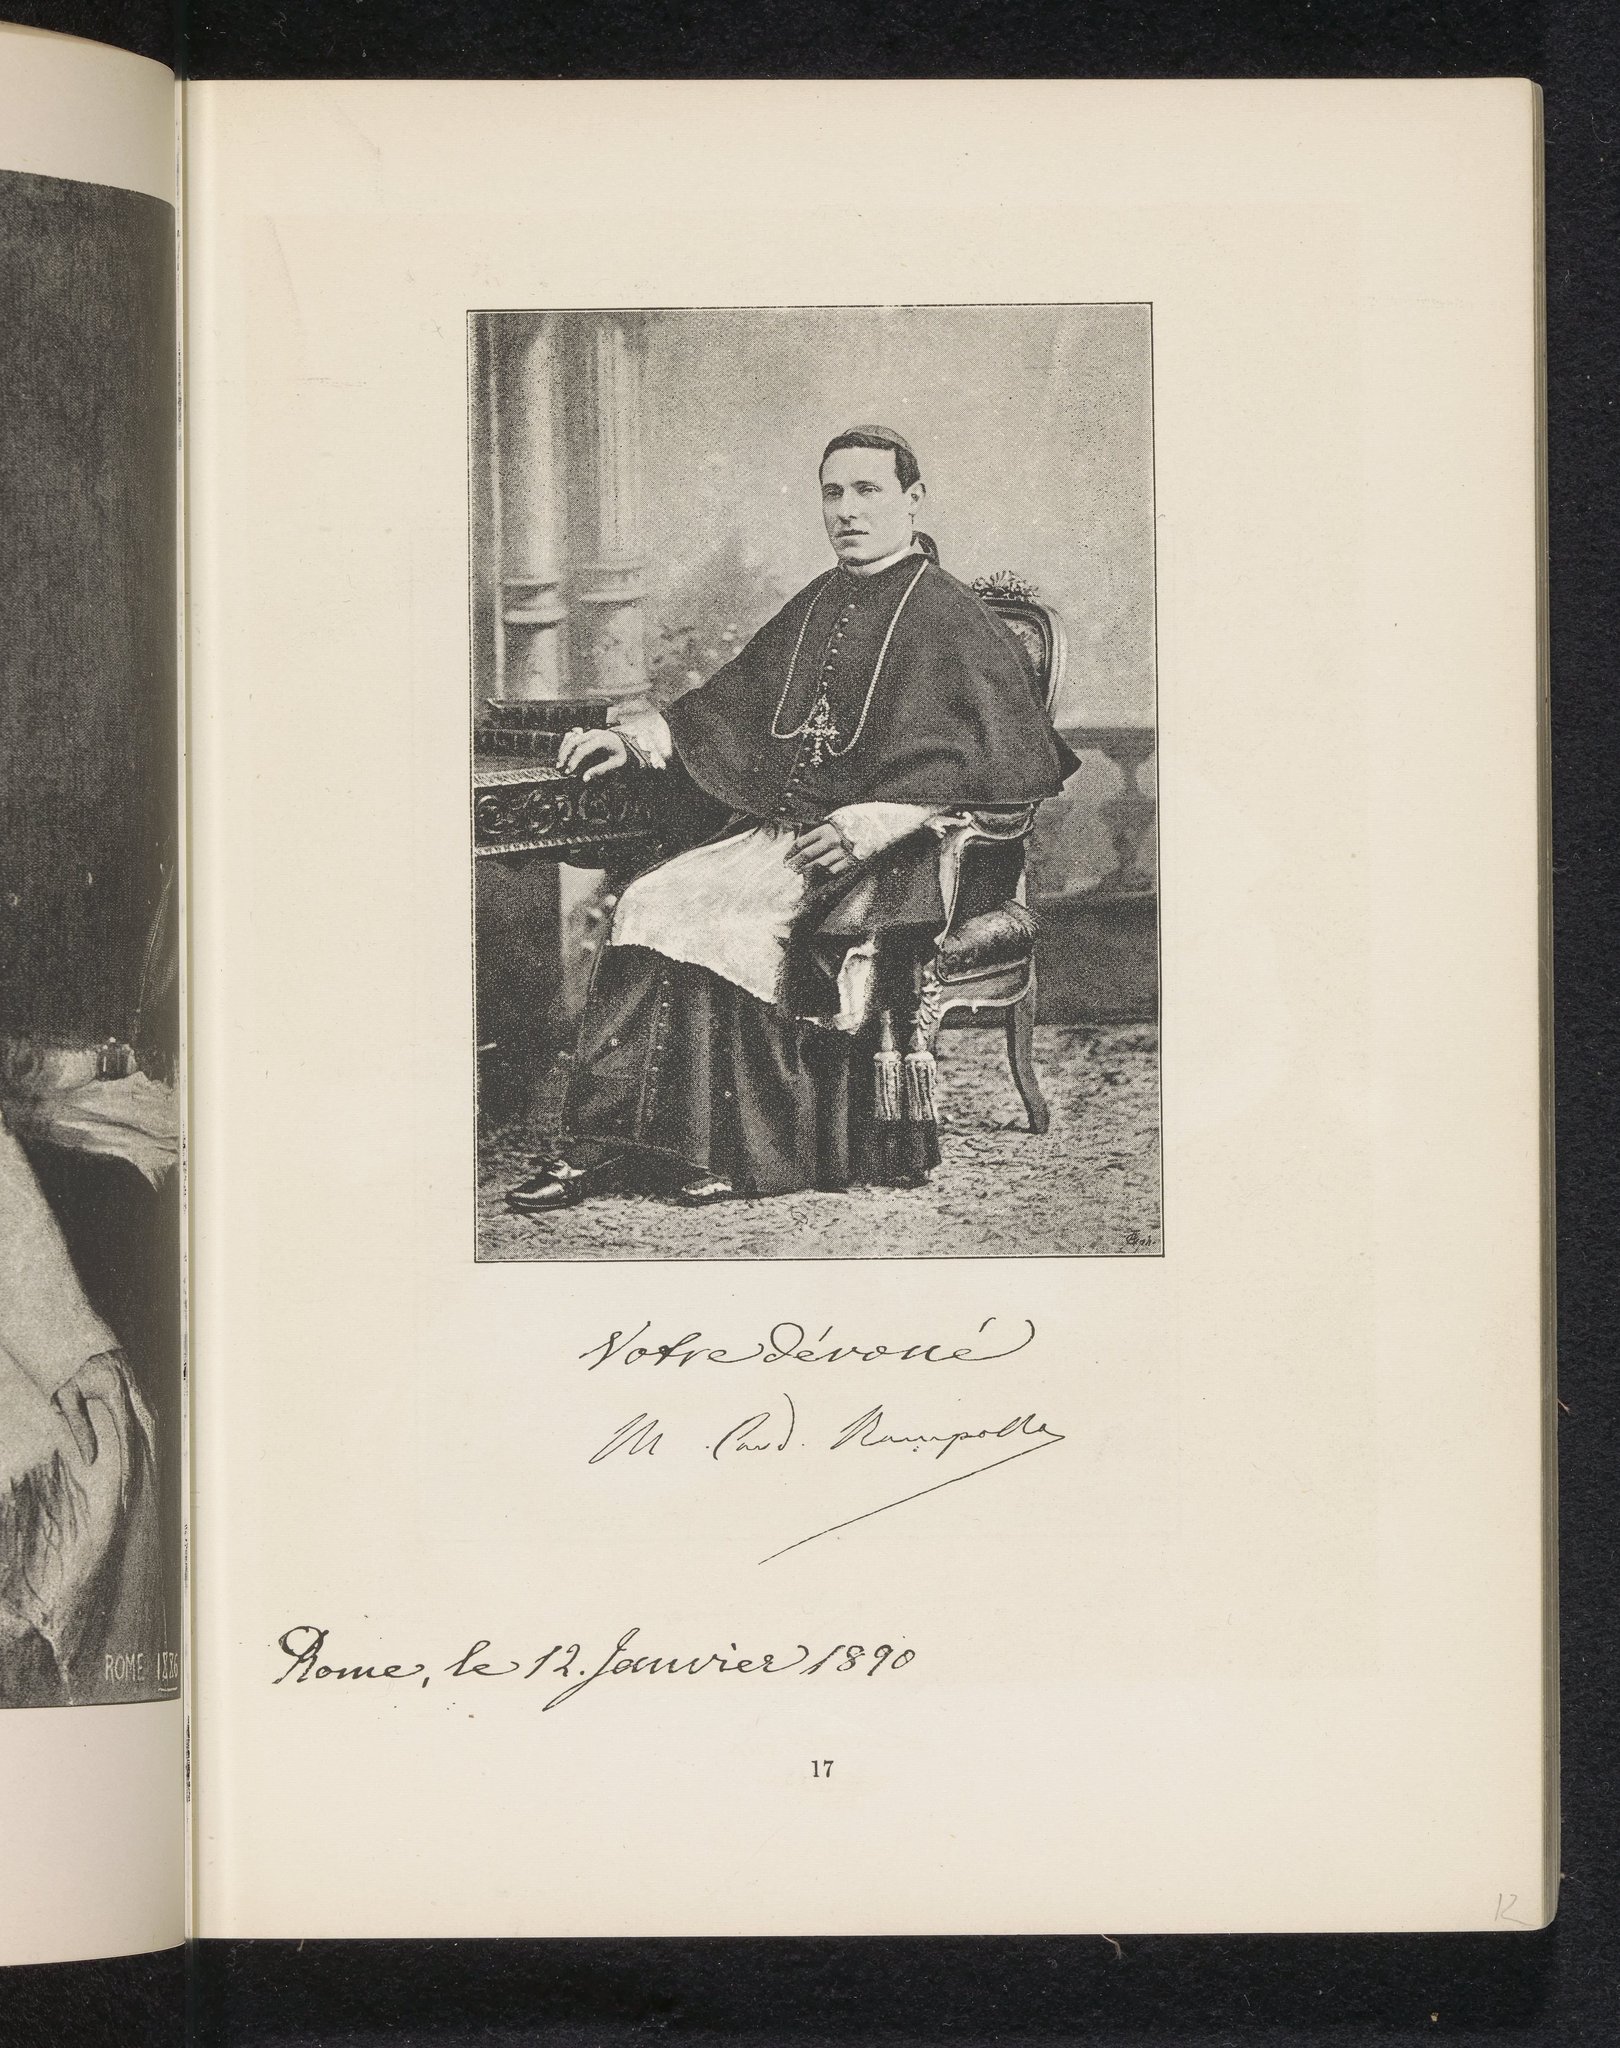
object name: photomechanical print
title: Portret van kardinaal Rampolla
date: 1881-1891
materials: paper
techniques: autotype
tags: cardinal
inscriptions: inscription